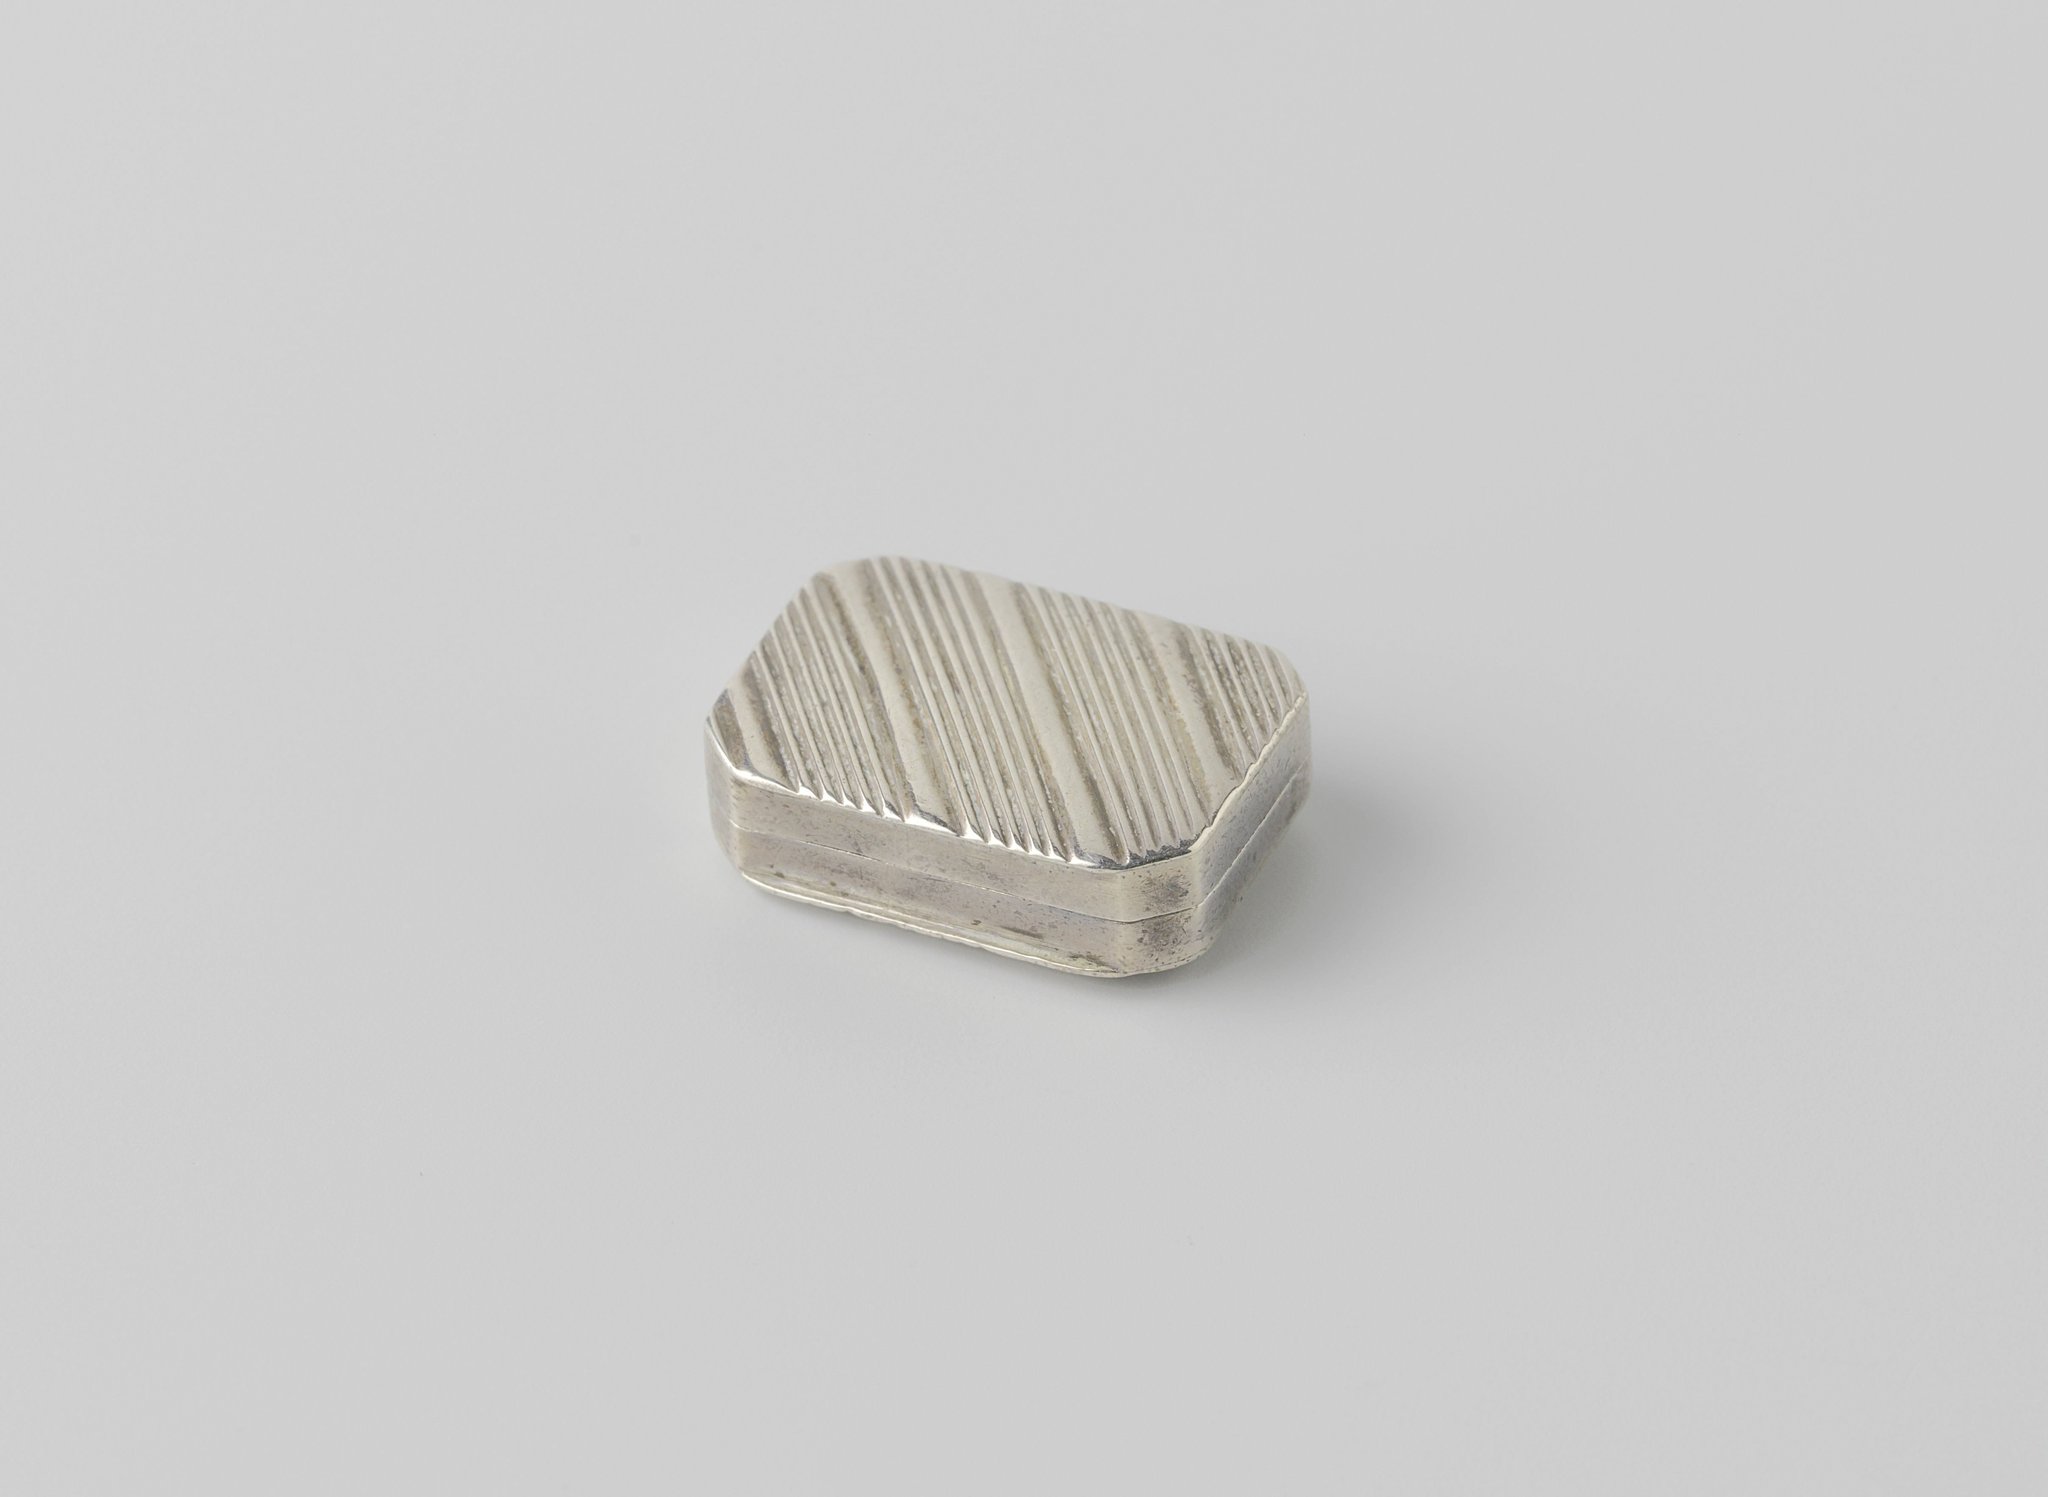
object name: vessel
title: Vinaigrettehouder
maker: joseph taylor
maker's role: silversmith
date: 1814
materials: silver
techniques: gilding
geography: birmingham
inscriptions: mark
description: Vinaigrettehouder van gedeeltelijk verguld zilver, rechthoekig met afgeschuinde hoeken. Het bestaat uit 2 delen van gelijke grootte, die aan een van de lange zijden scharnierend aan elkaar bevestigd zijn.